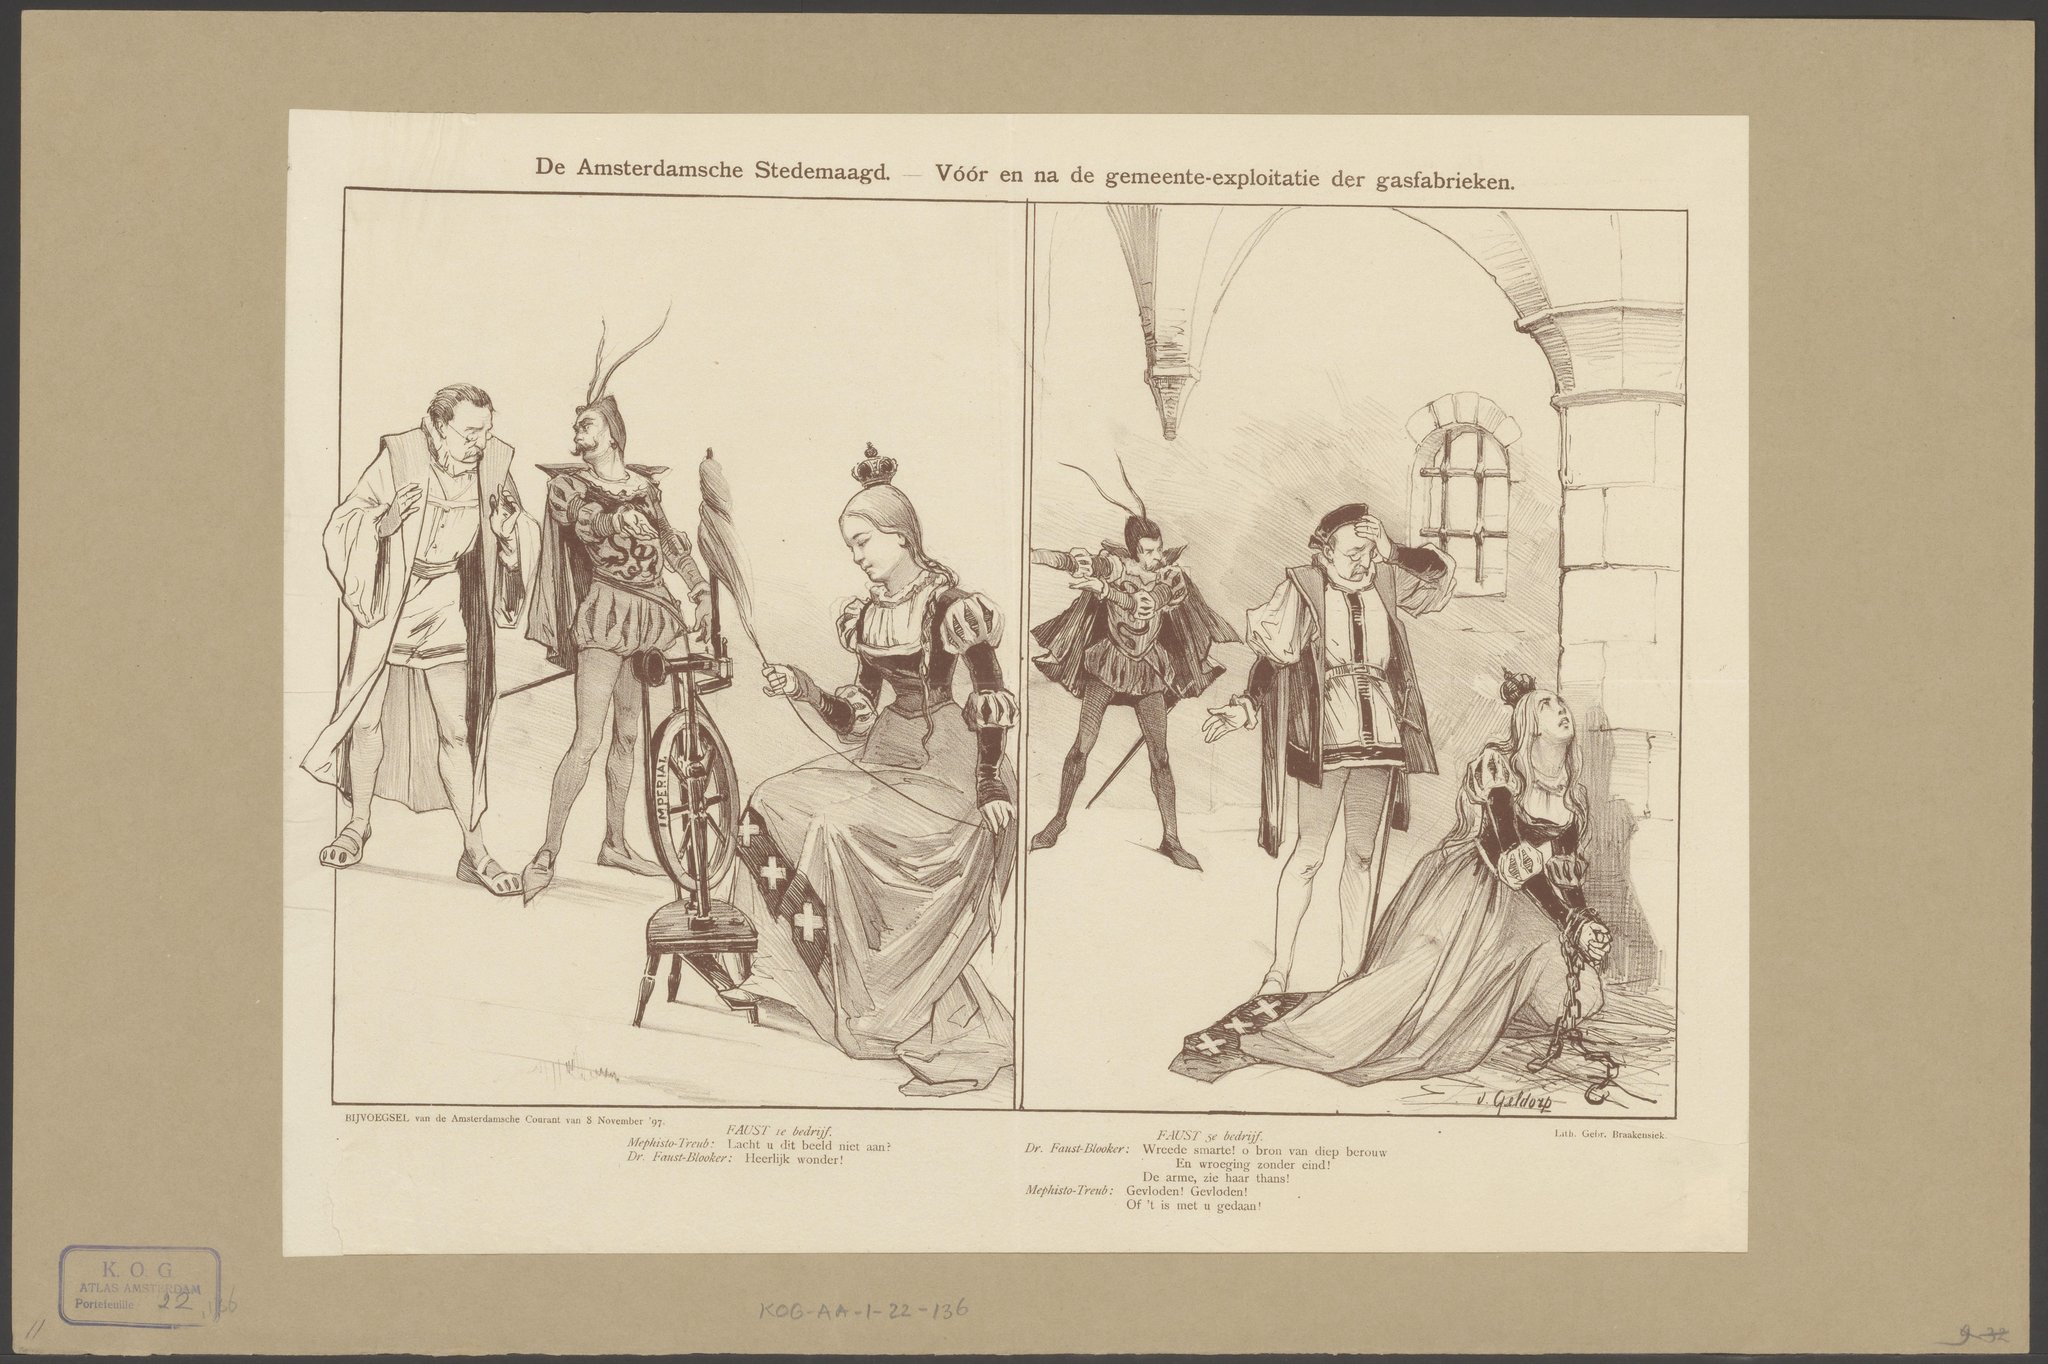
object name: cartoon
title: De Amsterdamse Stedenmaagd. - Vóór en na de gemeente-exploitatie der gasfabrieken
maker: petrus van geldorp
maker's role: draughtsman, print maker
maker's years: 1872-1939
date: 1898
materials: paper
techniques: letterpress printing, lithograph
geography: amsterdam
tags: voorschoten, the hague, politician, personification of a city, town-patron(ess), spinning-wheel, faust, mephistopheles, name of the demonic tempter in the literary versions of the faust legends, political caricatures and satires, amsterdam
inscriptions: collector's mark: Lugt 1641b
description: Gepubliceerd als bijvoegsel van 'De Amsterdamsche Courant', 8 november 1897.